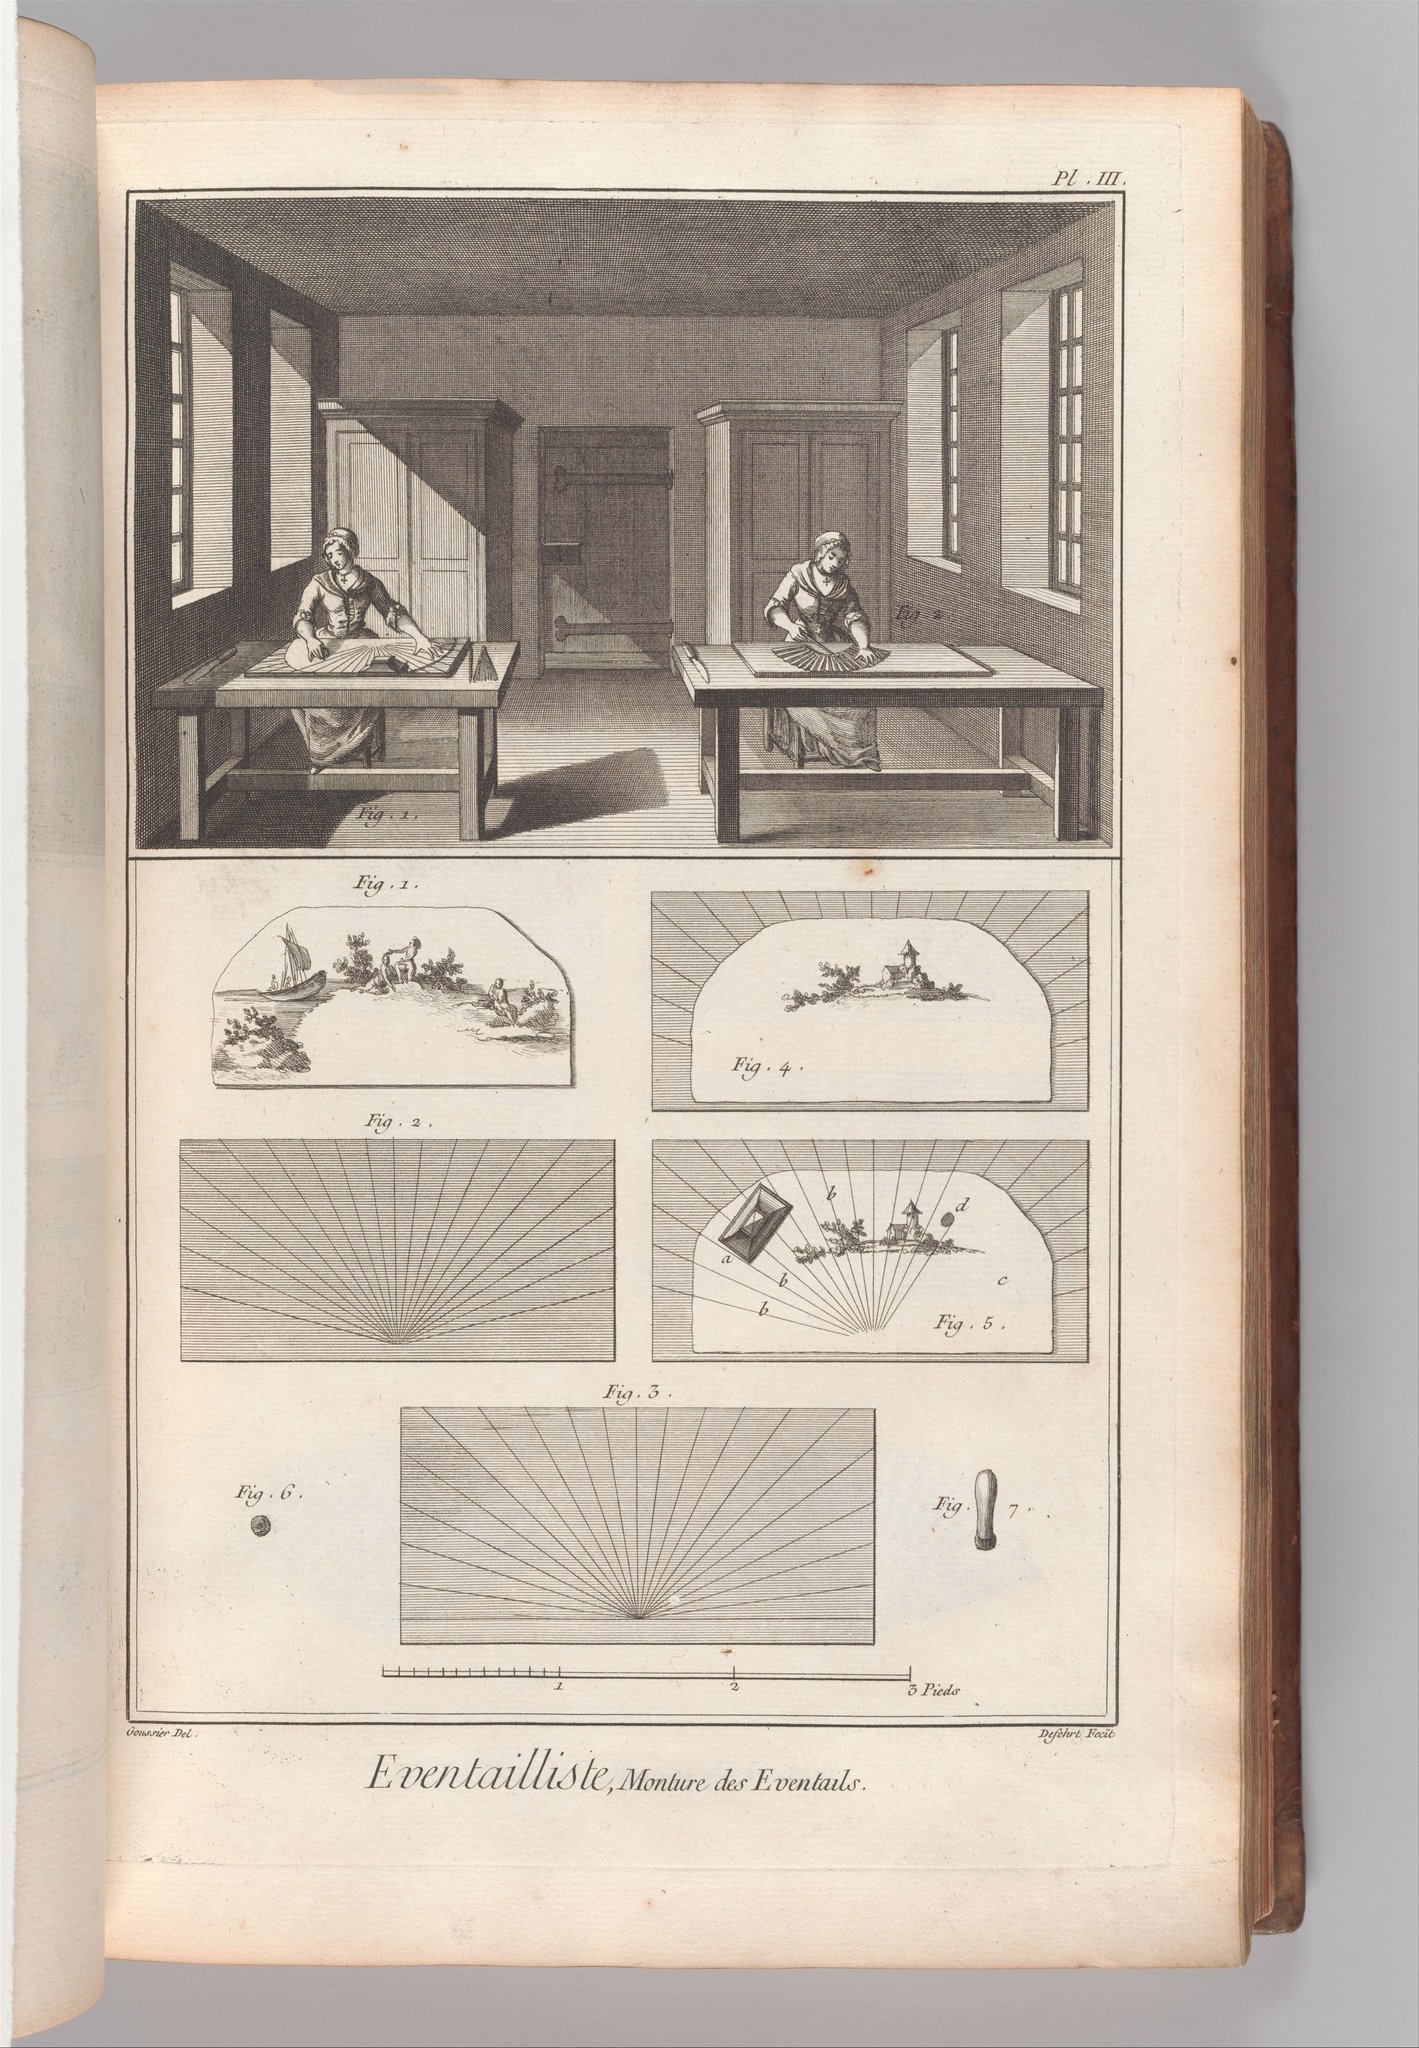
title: Recueil de planches, sur les sciences, les arts libéraux, et les arts méchaniques : avec leur explication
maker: denis diderot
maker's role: author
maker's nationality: french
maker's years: 1713-1784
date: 1762-1772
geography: france